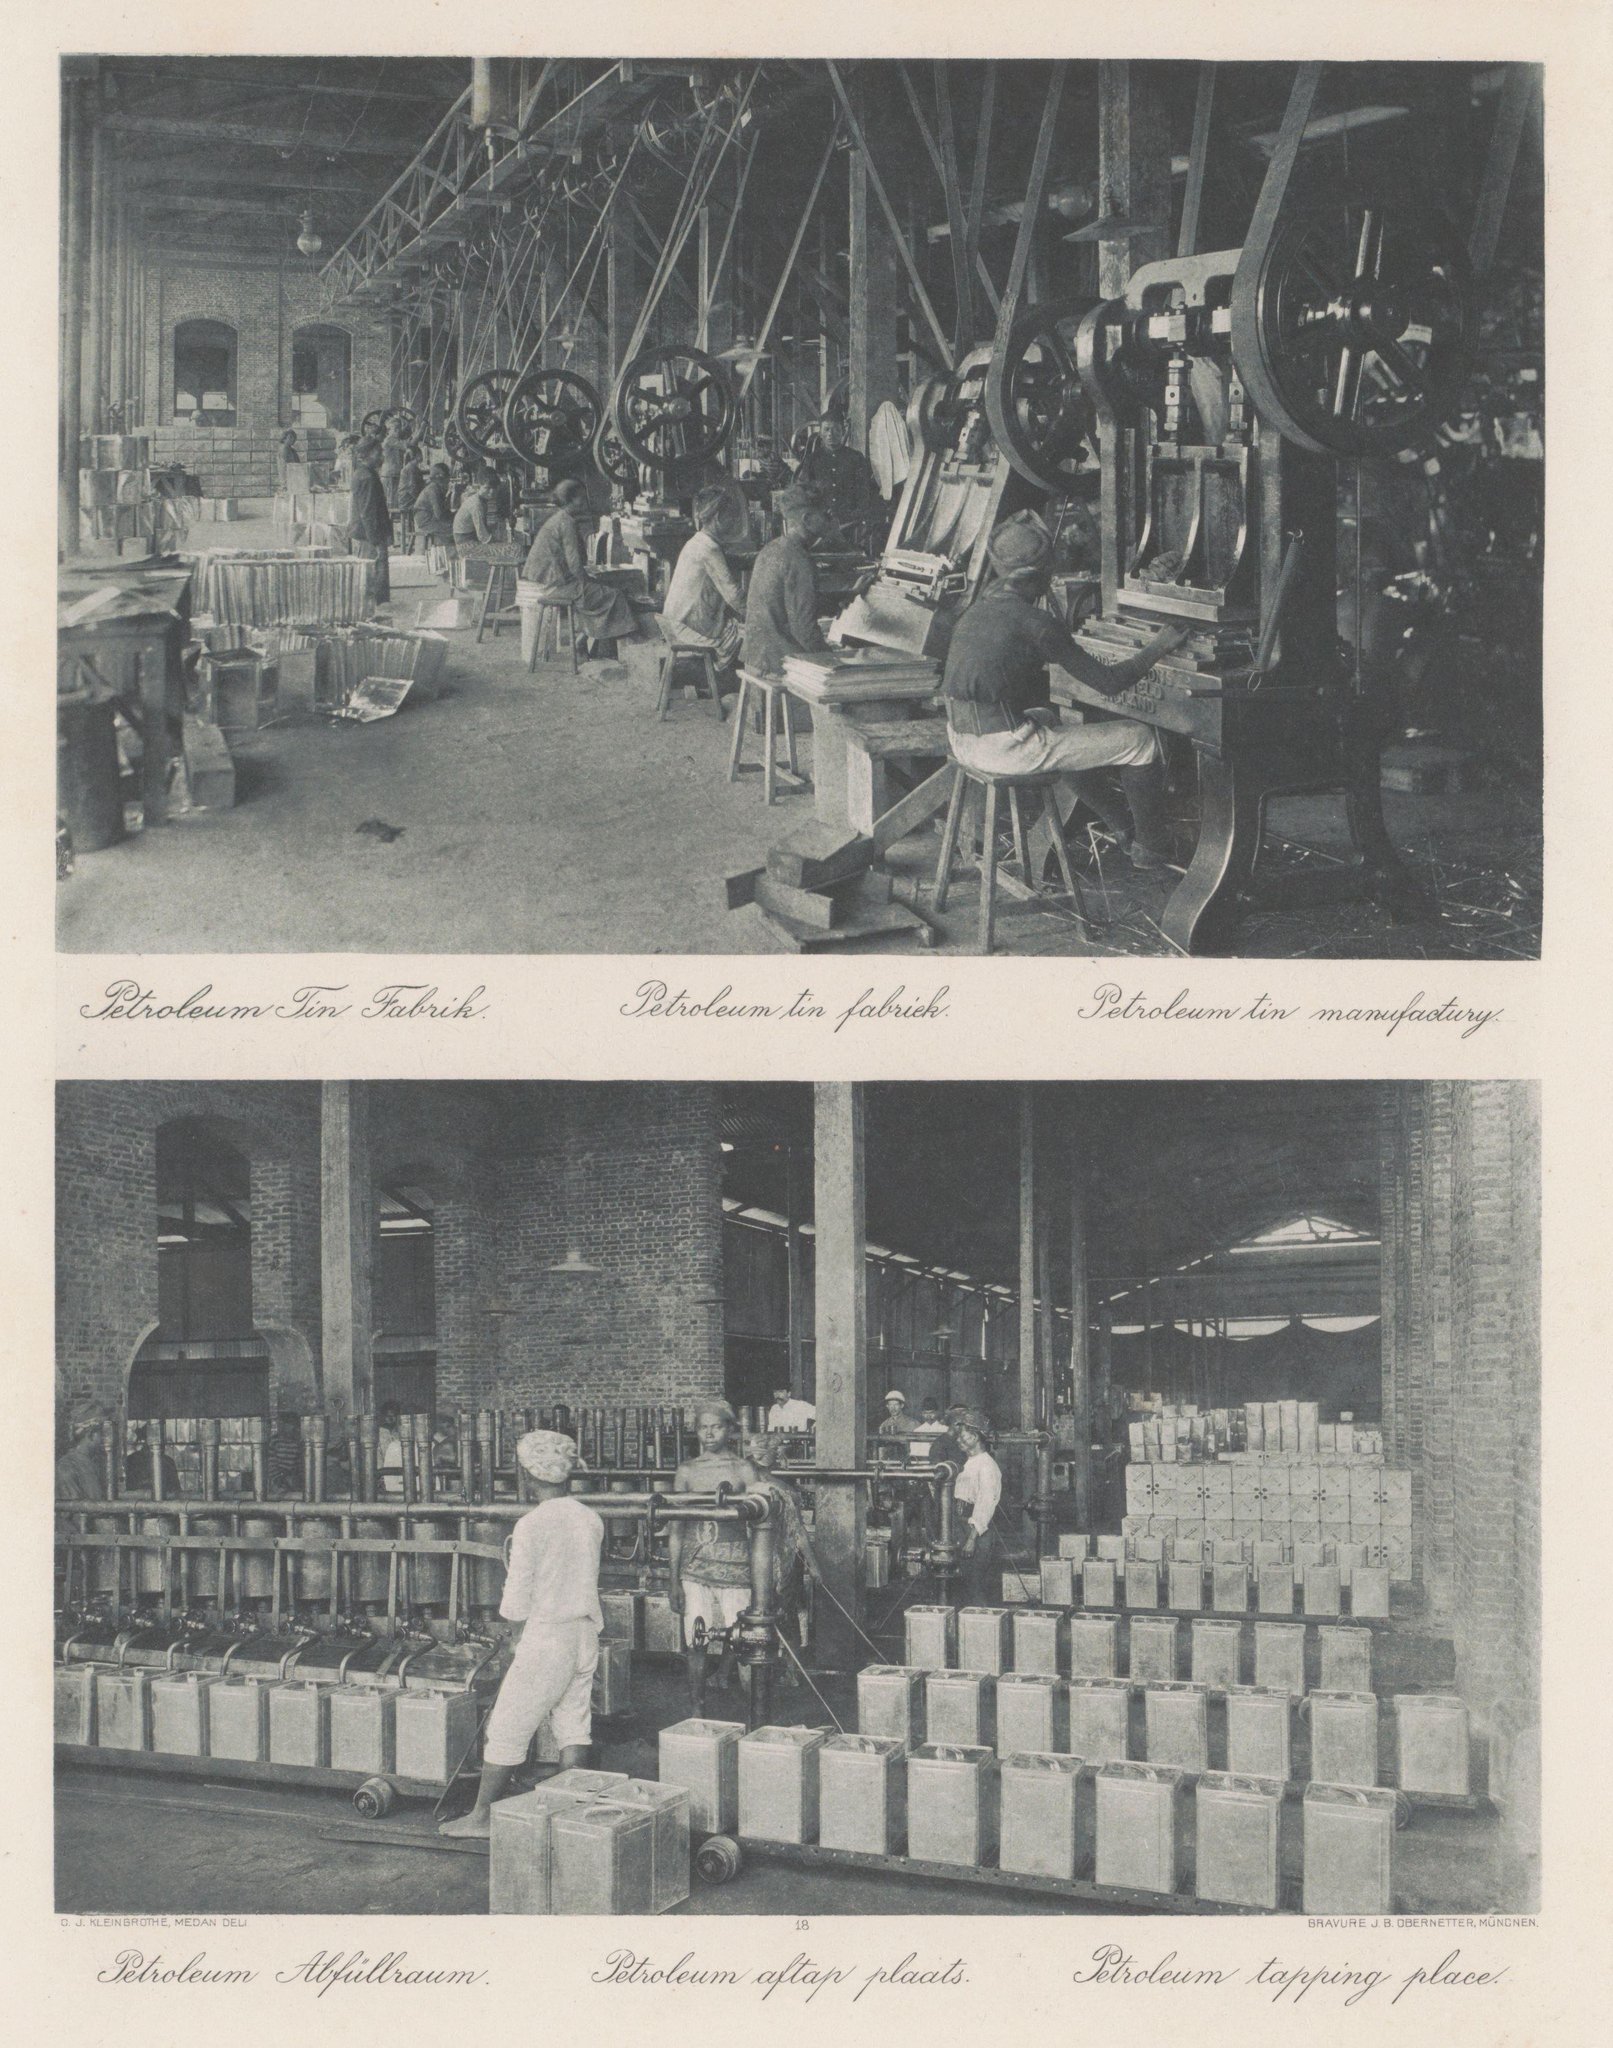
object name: photomechanical print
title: Interieur van een petroleum tinfabriek (boven) en van een petroleumaftapplaats (onder) op Sumatra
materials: paper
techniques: photoaquatint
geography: sumatra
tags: oil; oil refinery, workshop-interior, sumatra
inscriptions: number: ‘18’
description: Onderdeel van Album met heliogravures van Sumatra's oostkust.